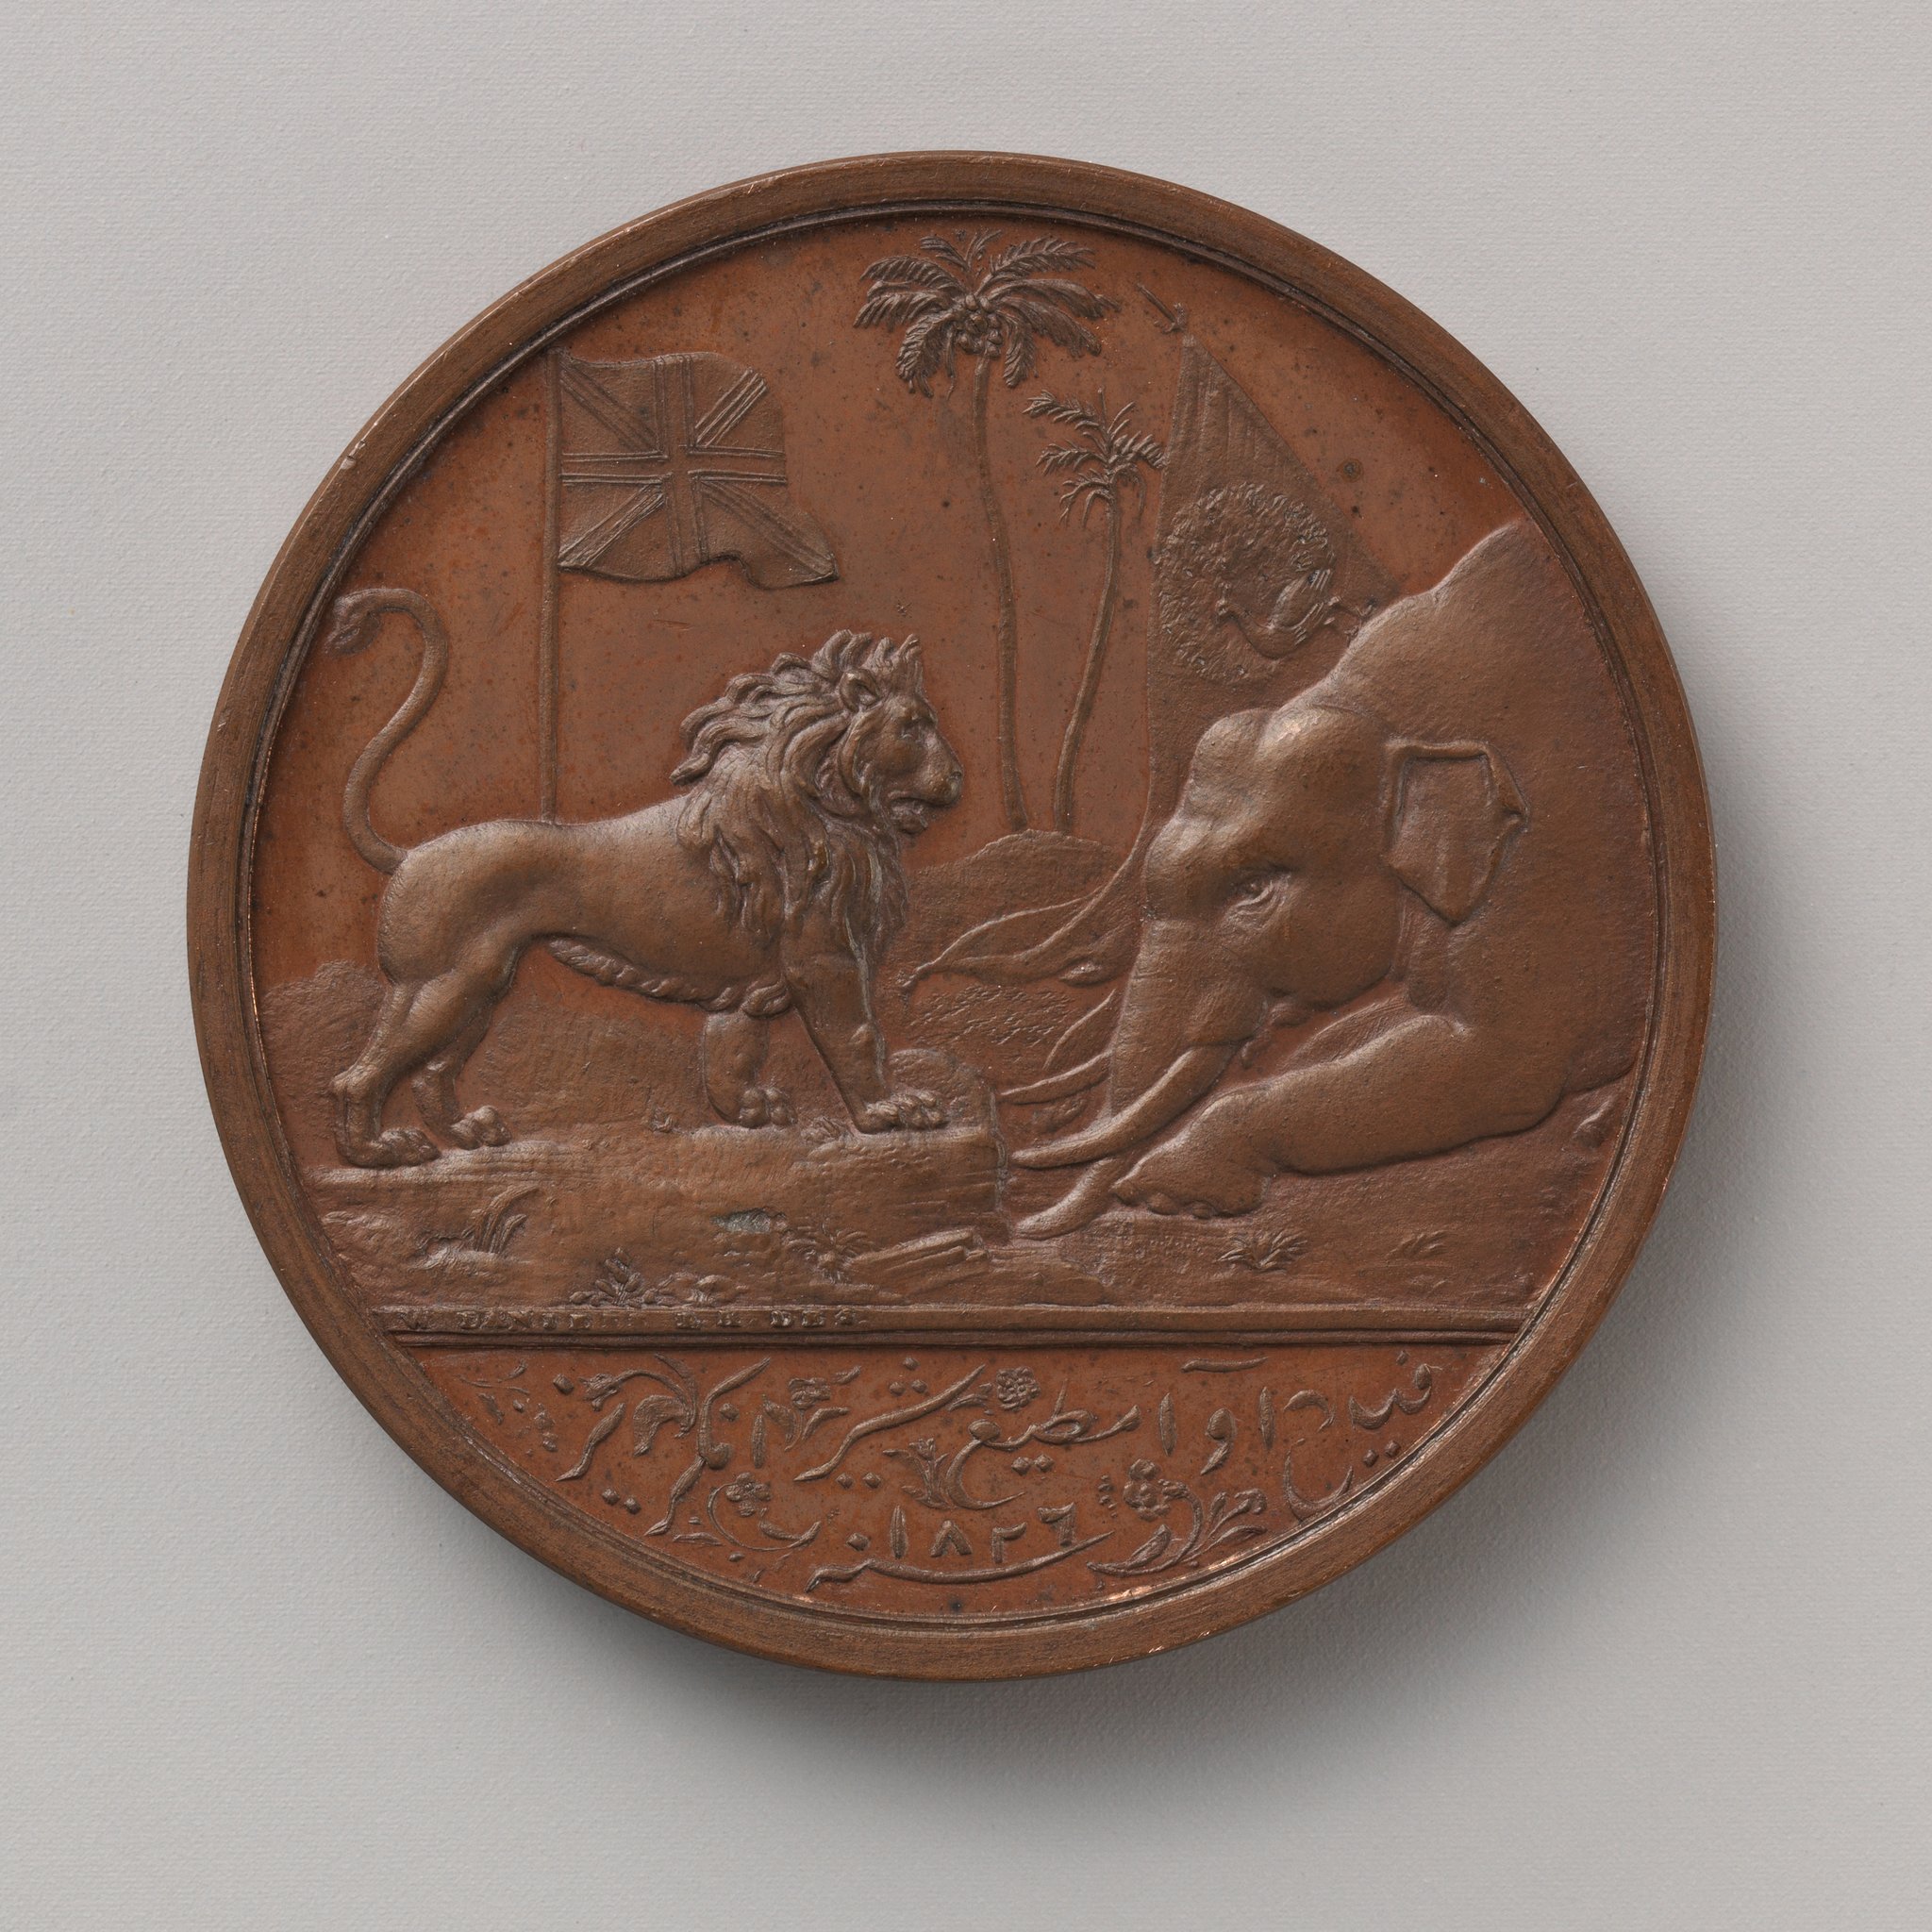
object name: medal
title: The Burmah Medal, 1824–26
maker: william wyon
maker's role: artist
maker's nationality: british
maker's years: 1795-1851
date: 1826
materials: bronze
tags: soldiers,peacocks,elephants,lions